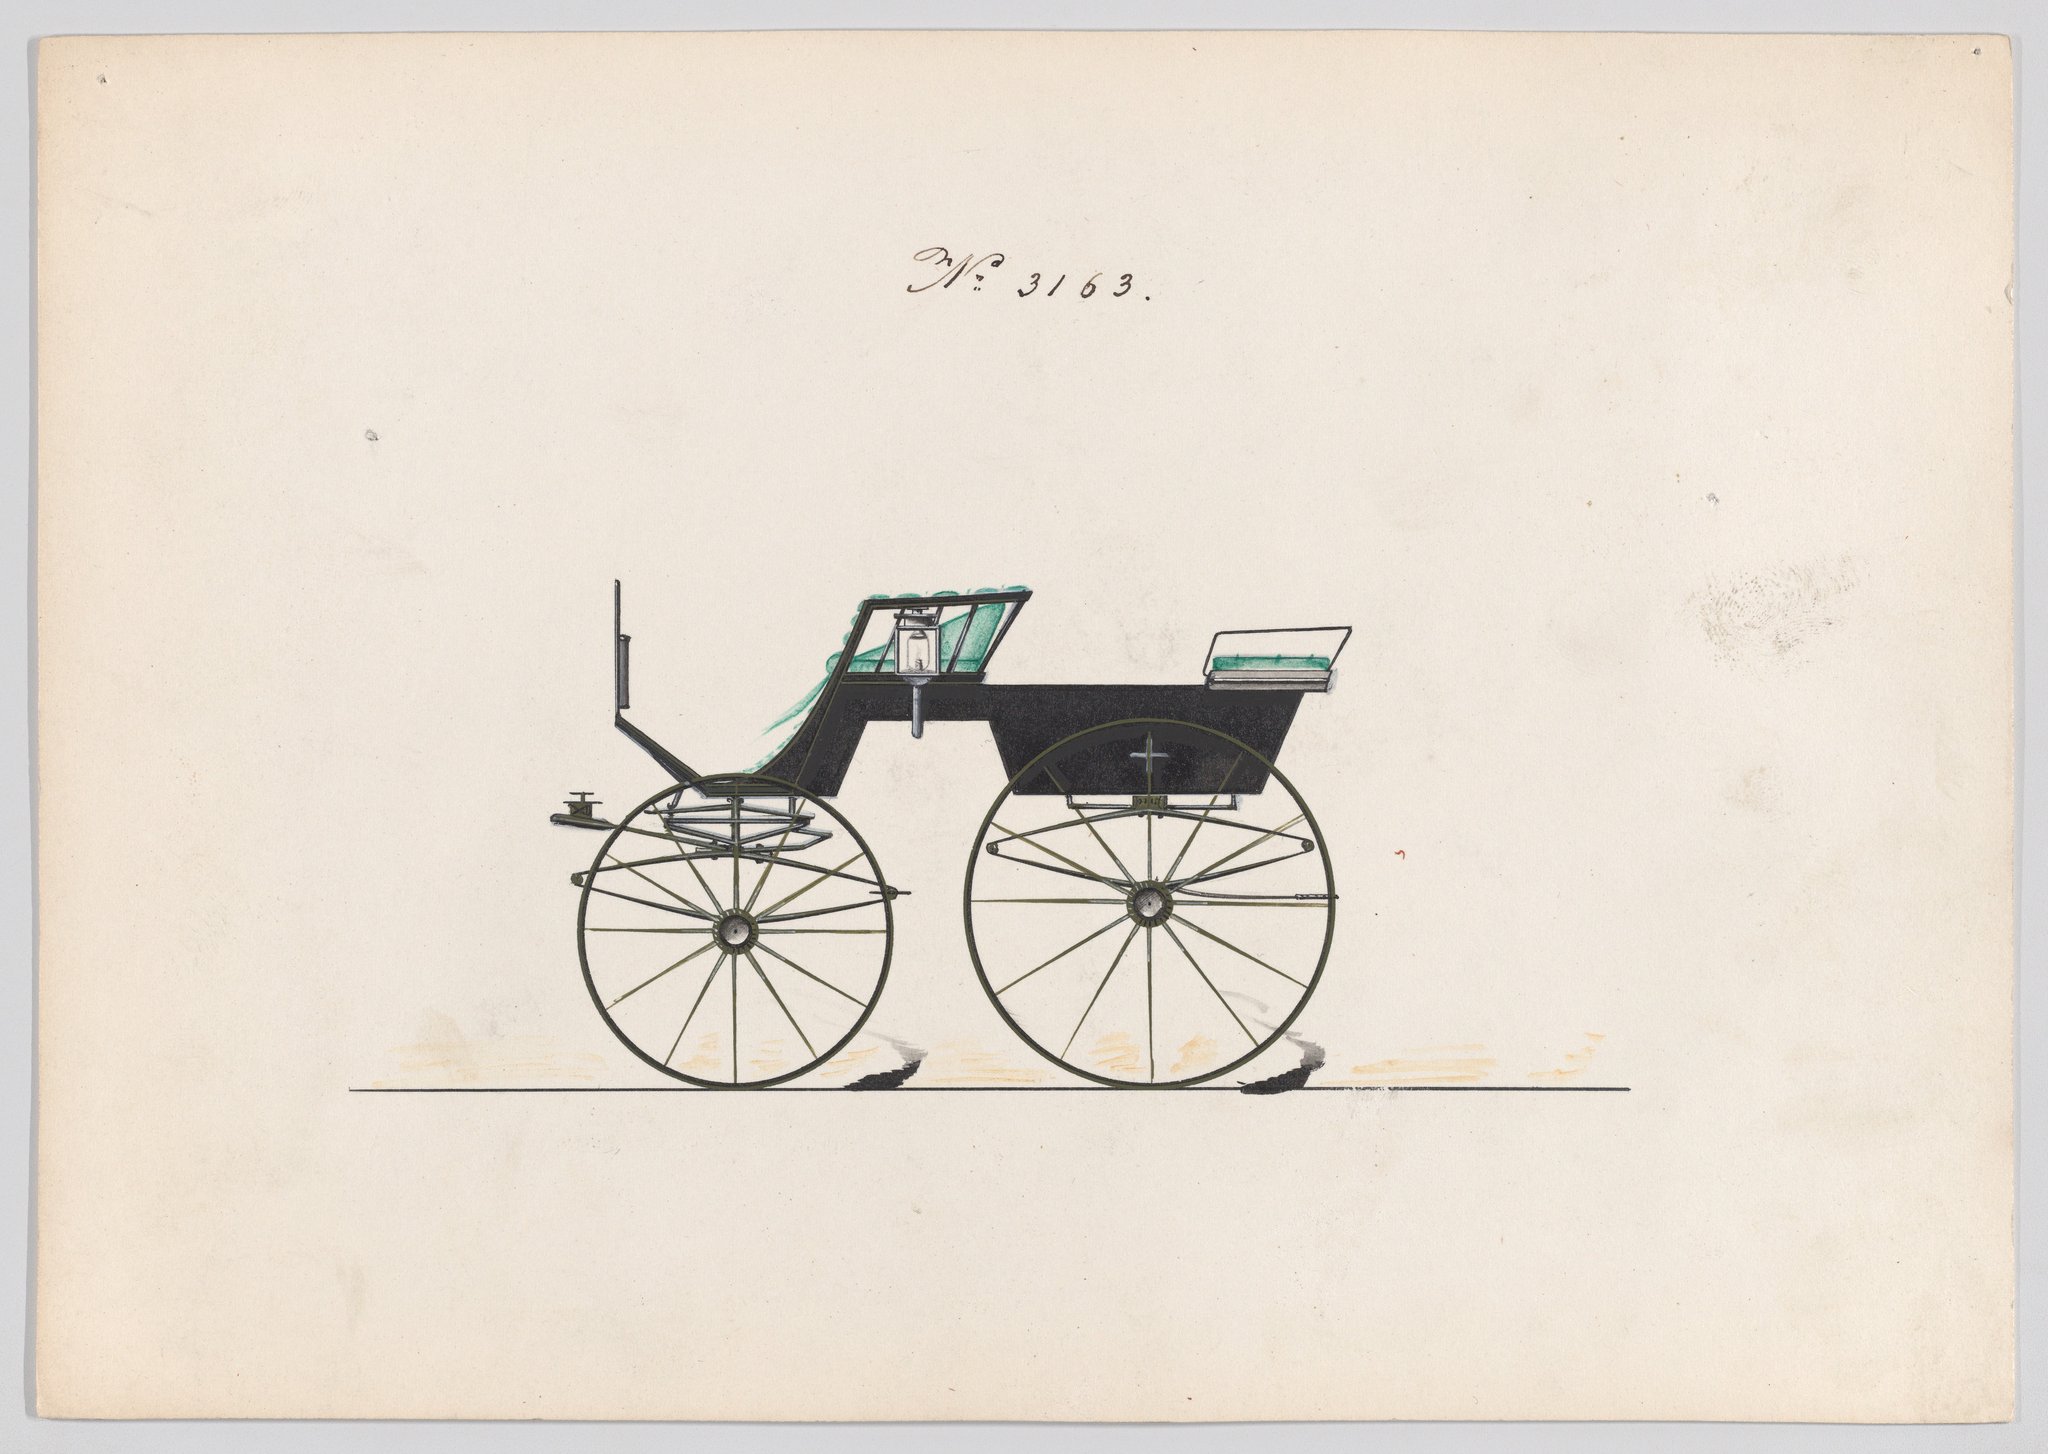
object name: drawing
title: Design for T-Cart, no. 3163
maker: brewster & co.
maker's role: manufacturer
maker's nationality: american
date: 1875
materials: gouache, gum arabic, ink, watercolor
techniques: pen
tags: carriages